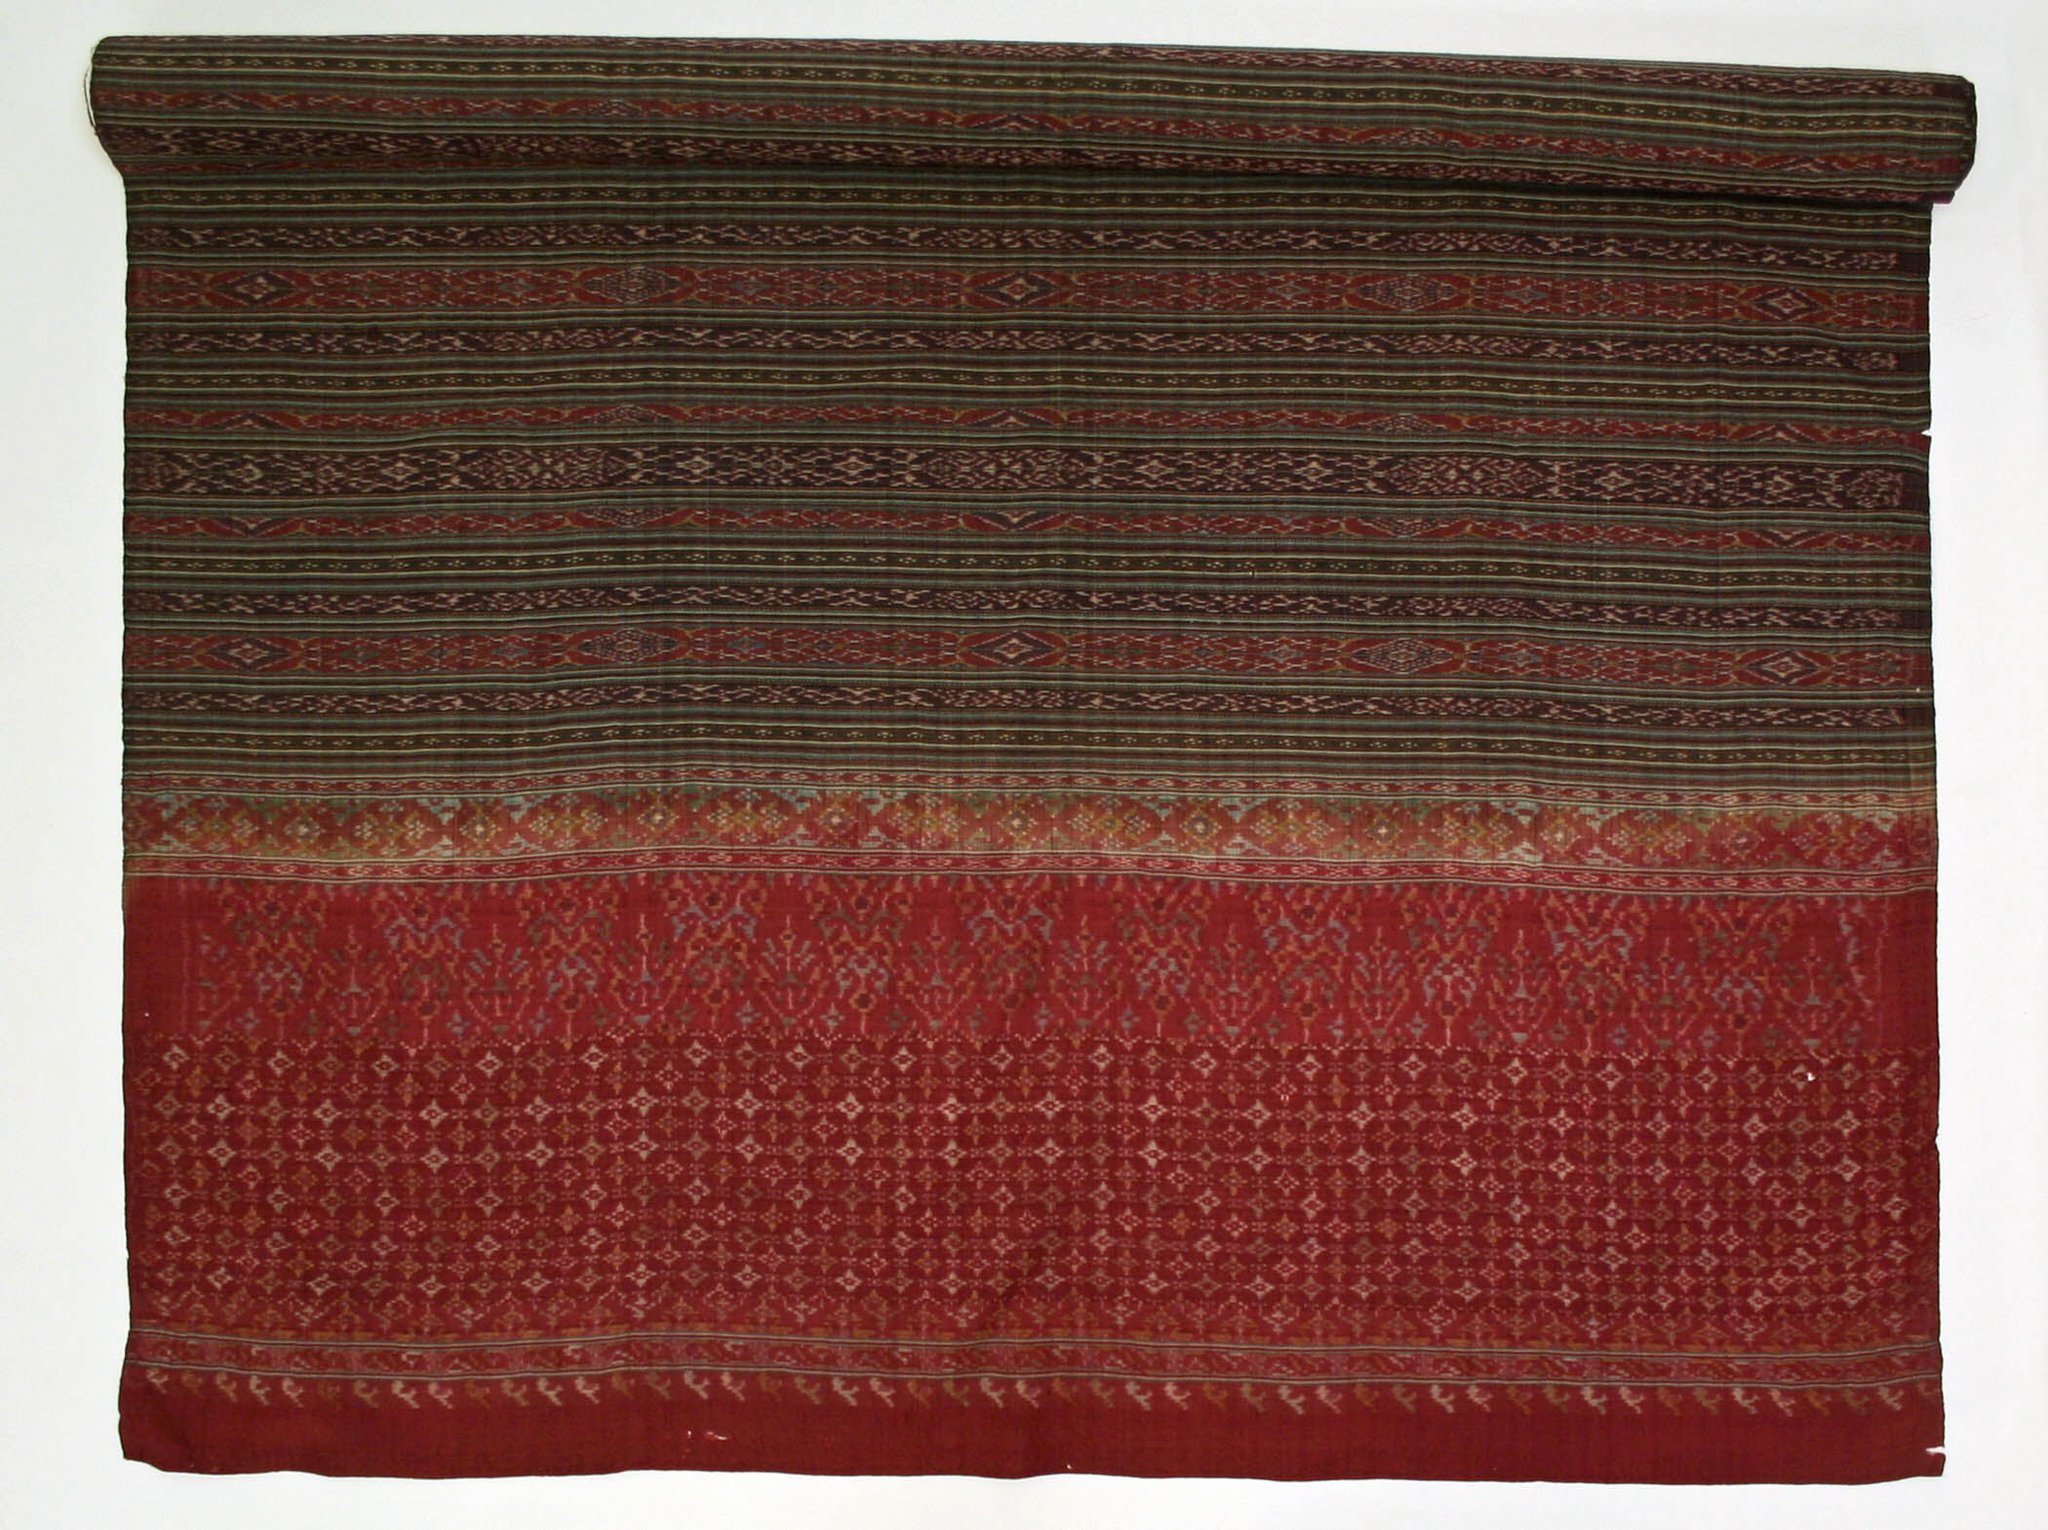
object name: skirt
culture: malaysian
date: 1867-1900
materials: silk